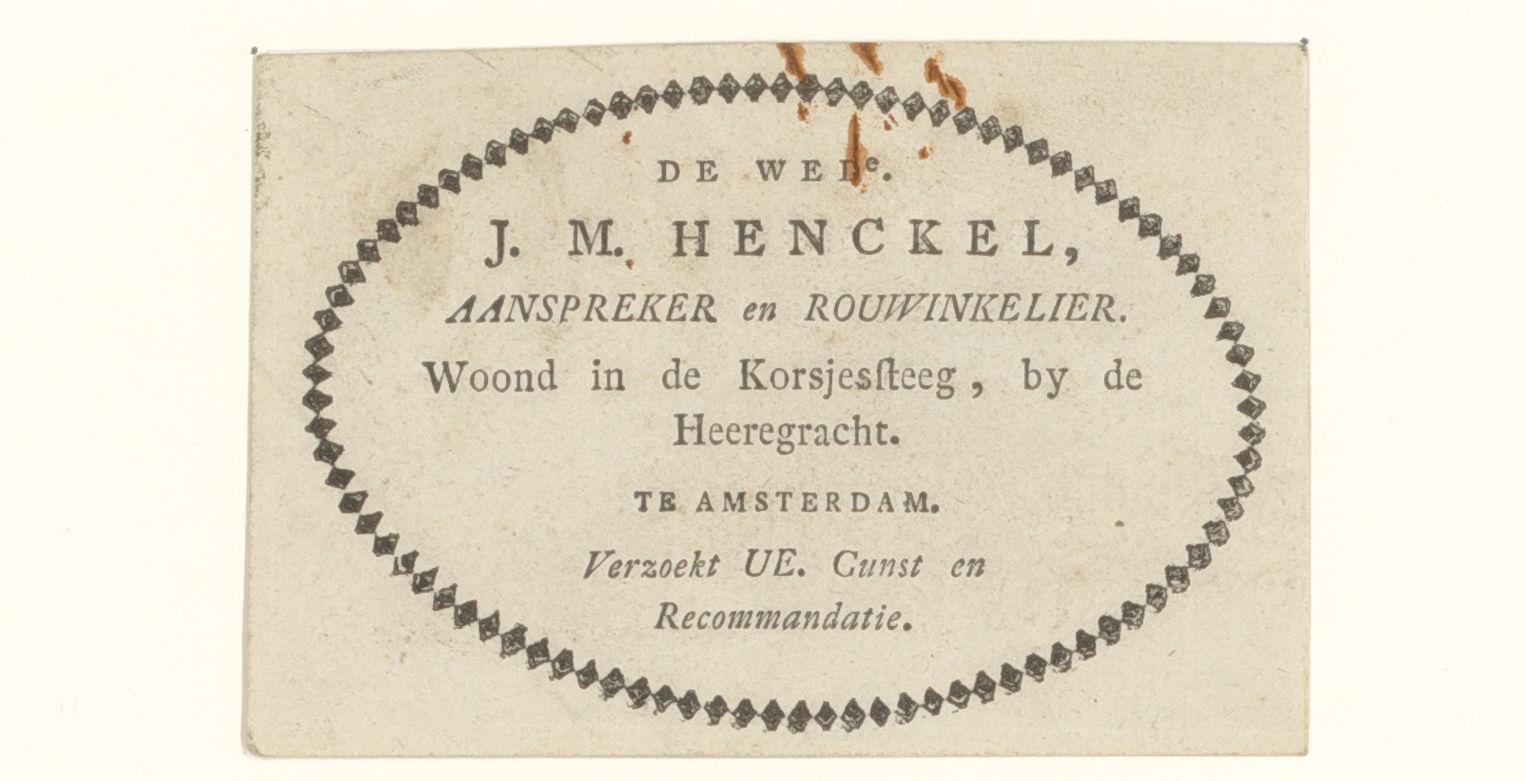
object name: text sheet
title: Naamkaartje van de aanspreker J.M. Henckel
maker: Anonymous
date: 1800-1899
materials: paper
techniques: letterpress printing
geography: amsterdam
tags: oral announcement (of death), undertaker's man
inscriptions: collector's mark, collector's mark: Lugt 1641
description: Naamkaartje van de aanspreker en 'rouwinkelier' J.M. Henckel, in de Korsjessteeg te Amsterdam. Onderwerpsrubrieken binnen de Atlas Zeden en Gewoonten: Des Menschen Begin, Midden en Einde. Begrafenissen, aansprekers, doodgravers, enz.